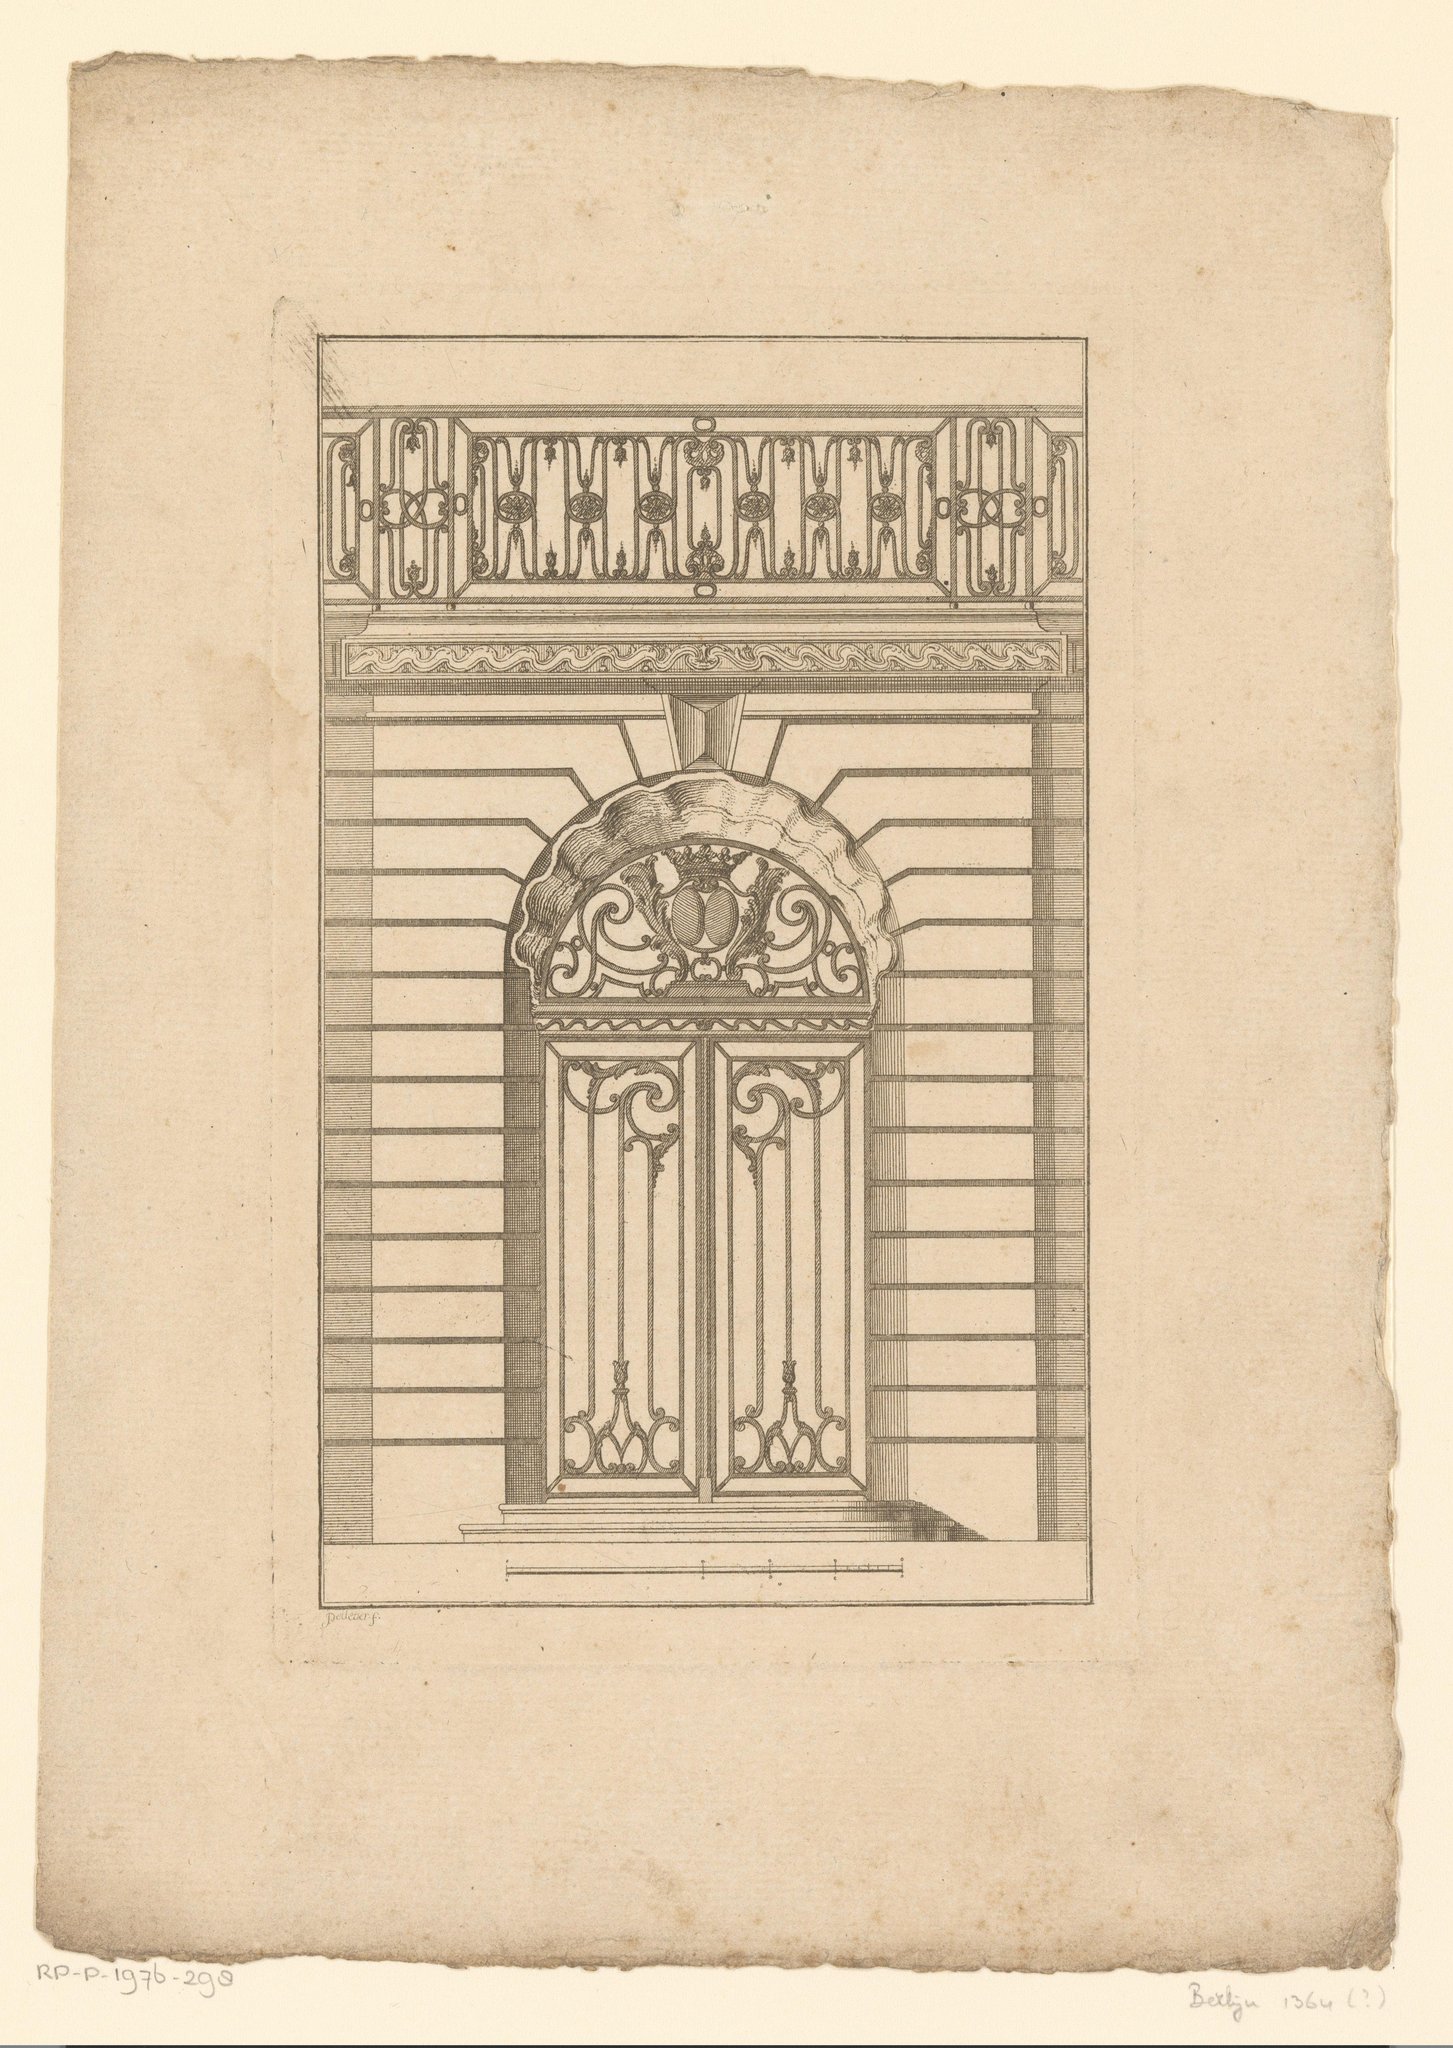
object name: print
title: Poort en balustrade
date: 1761-1762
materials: paper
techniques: engraving, etching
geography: paris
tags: gate, entrance, balustrade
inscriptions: collector's mark: Lugt 2228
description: Een geornamenteerd poorthek, halfrond aan de bovenzijde. Daarboven een geornamenteerde balustrade.